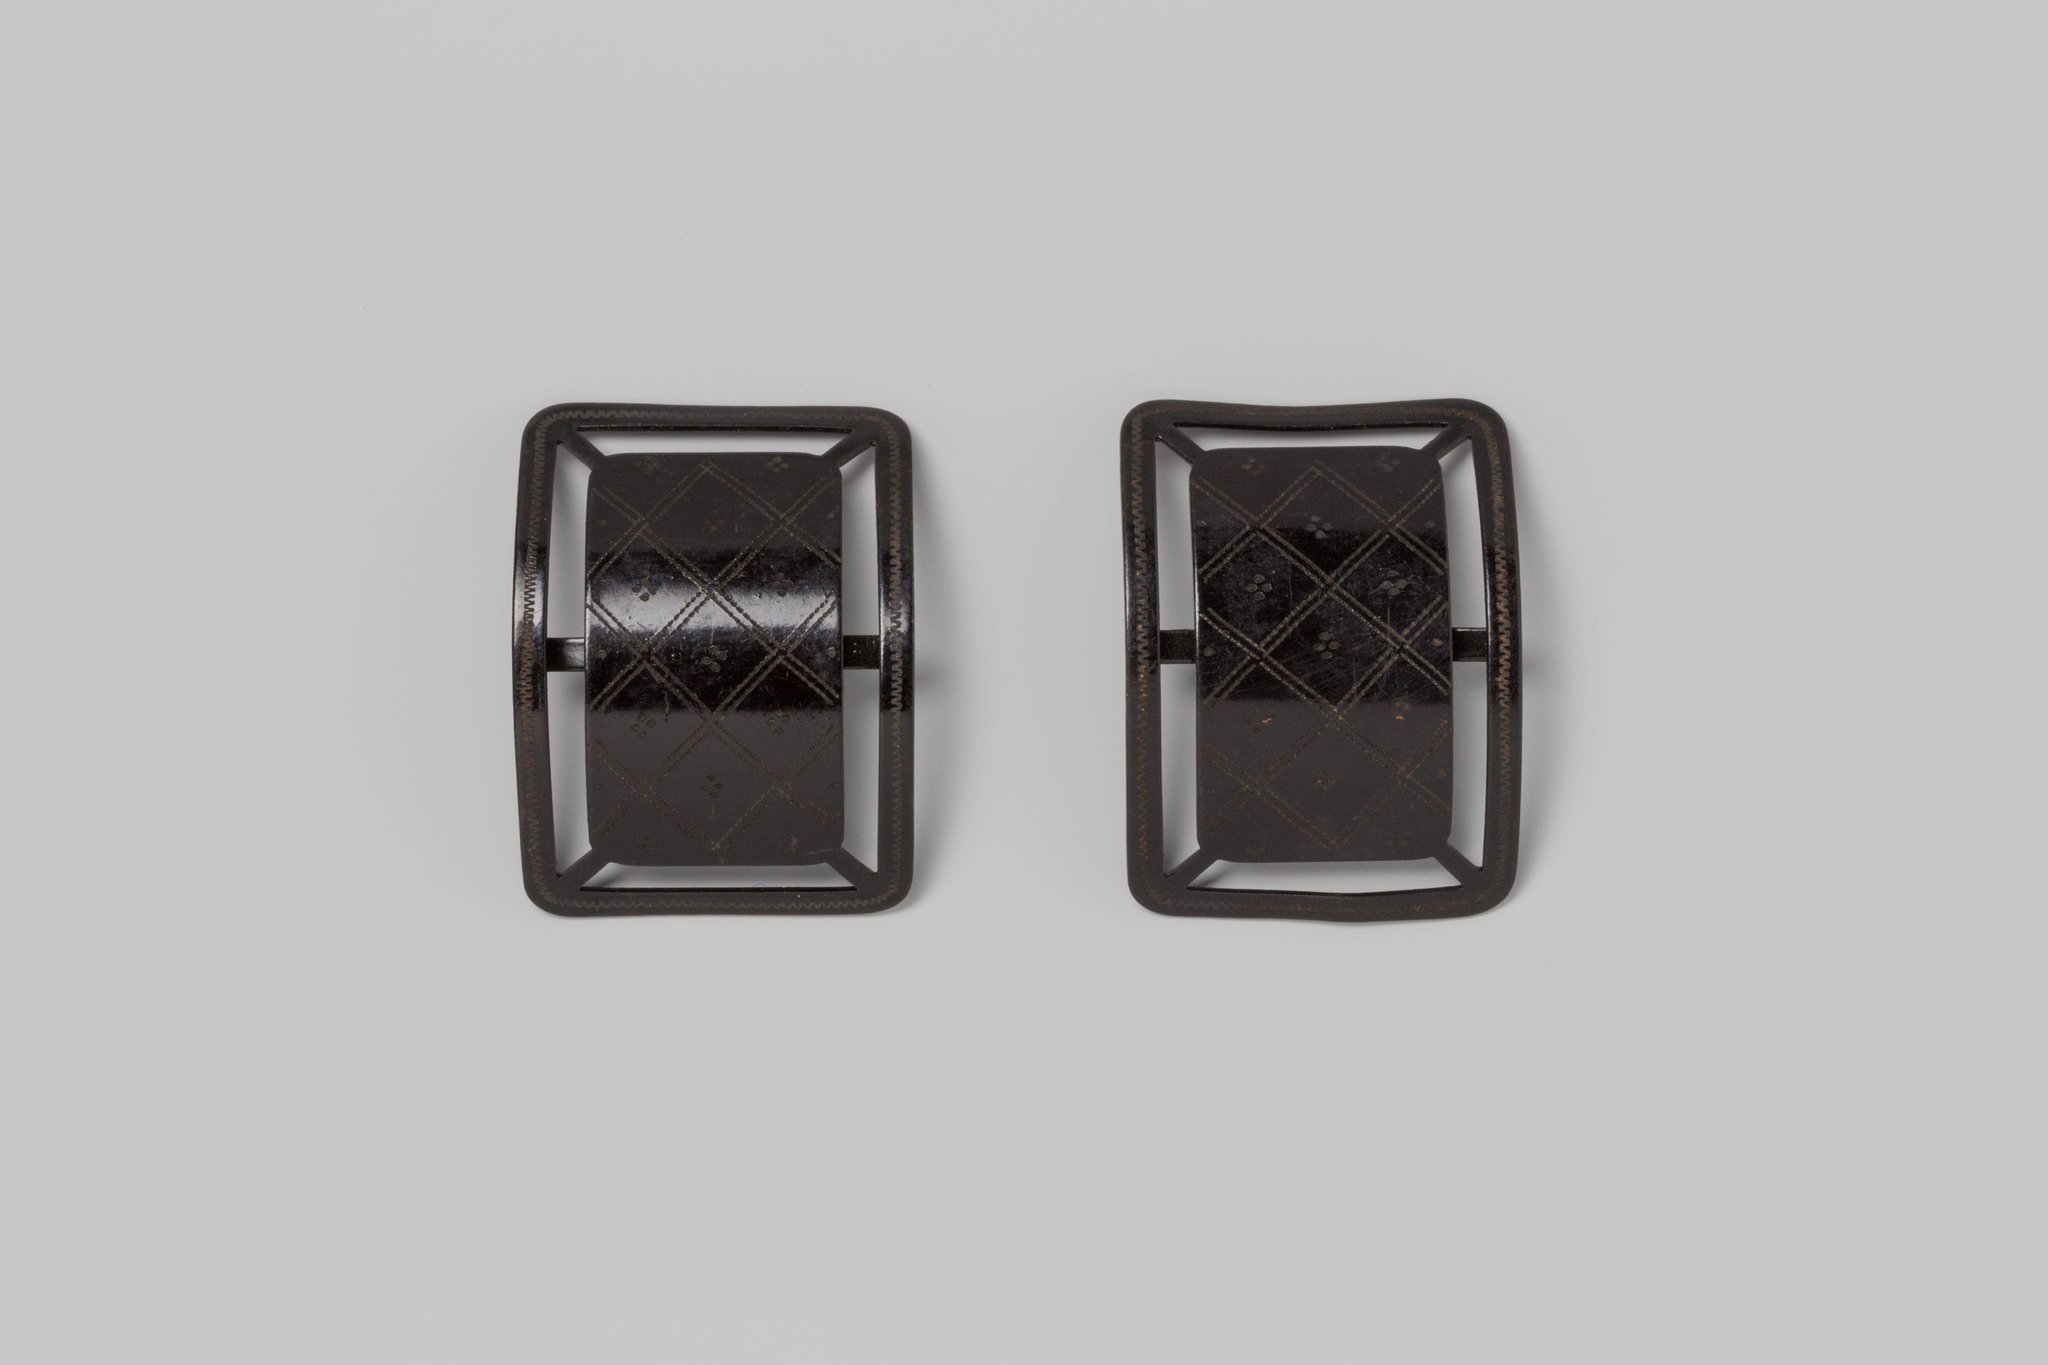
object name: shoe buckle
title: Rechthoekige en gebogen schoengesp van zwart gelakt metaal, met een gegraveerde versiering bestaande uit een ruitmotief met stippen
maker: Anonymous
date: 1880-1910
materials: lacquer, metal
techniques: engraving, punching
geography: netherlands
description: Schoengesp van zwart gelakt metaal, met ruitmotief. Model: Rechthoekig en gebogen, met vrij scherpe hoeken. Met à-jour geponste rand, Smalle bevestigingsbeugel met twee gaatjes. Versiering: Binnen een gesloten lijst staat een uitjespaard rechthoekig midden dat met schuine hoeklijnen is uitgesponst, zodat vier openingen zijn ontstaan. Het midden is gegraseerd met een gestippeld ruitmotief, waarbinnen telkens vier stripjes. Toestand: Dubeschadigd, niet gebruikt?